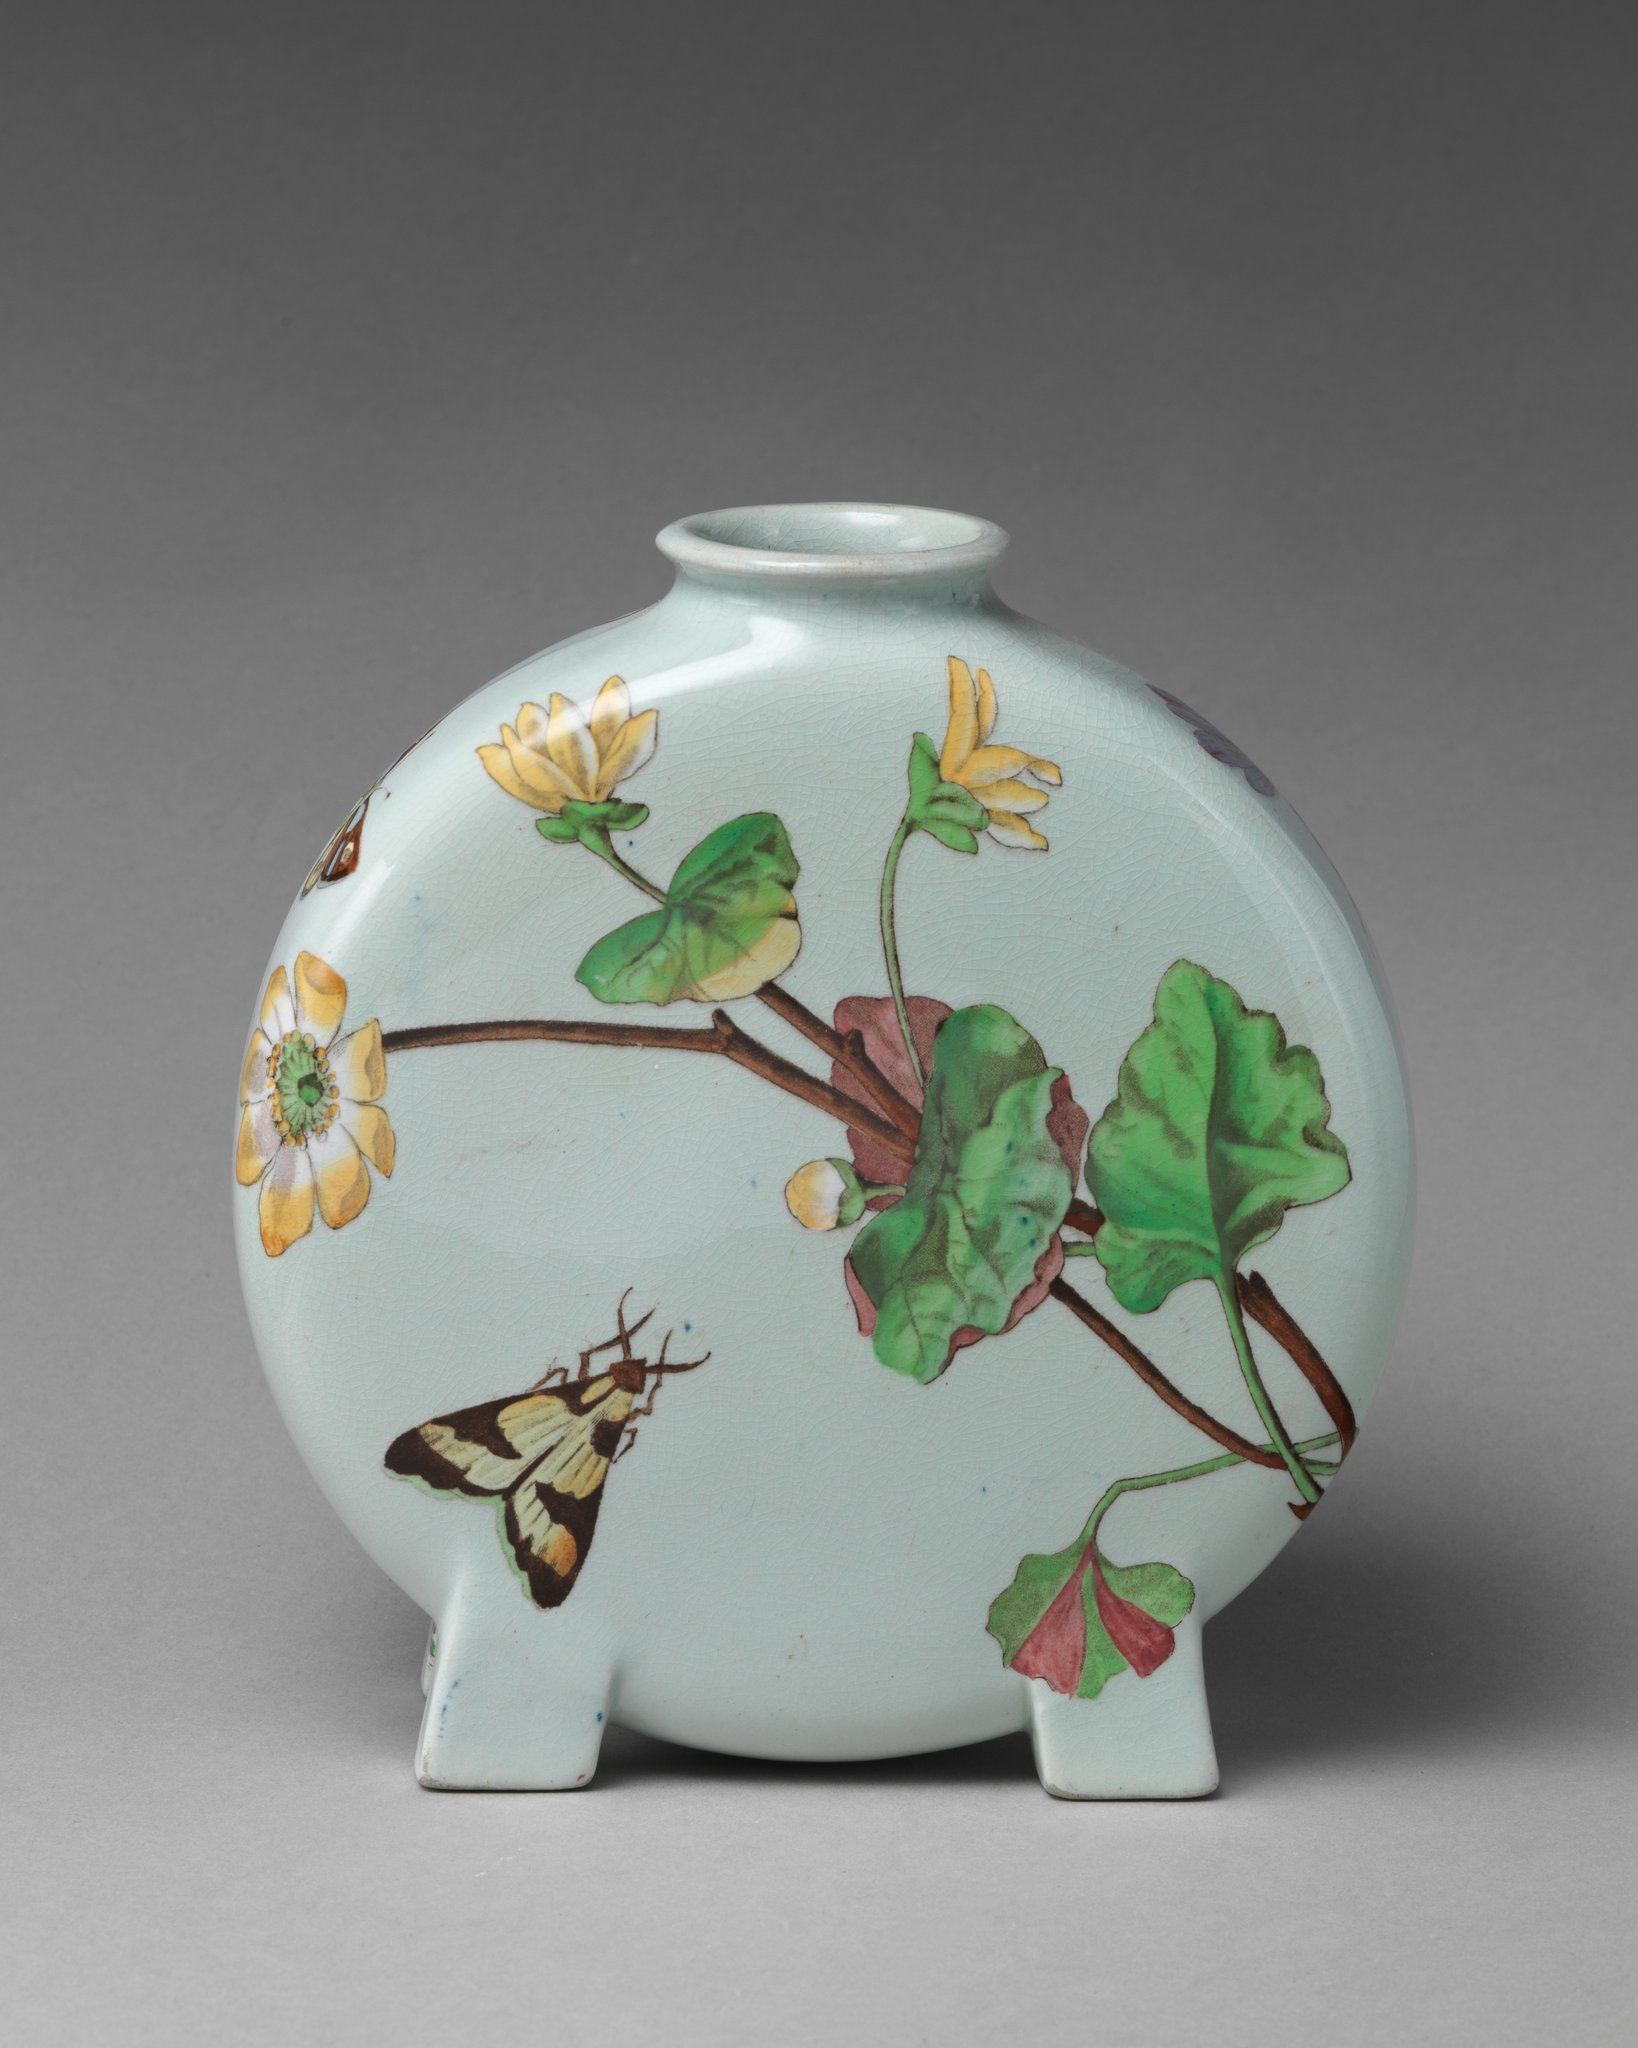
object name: pilgrim flask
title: Pilgrim flask with botanical spray and butterfly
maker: minton(s)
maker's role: maker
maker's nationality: british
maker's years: 1793-2001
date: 1877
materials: earthenware